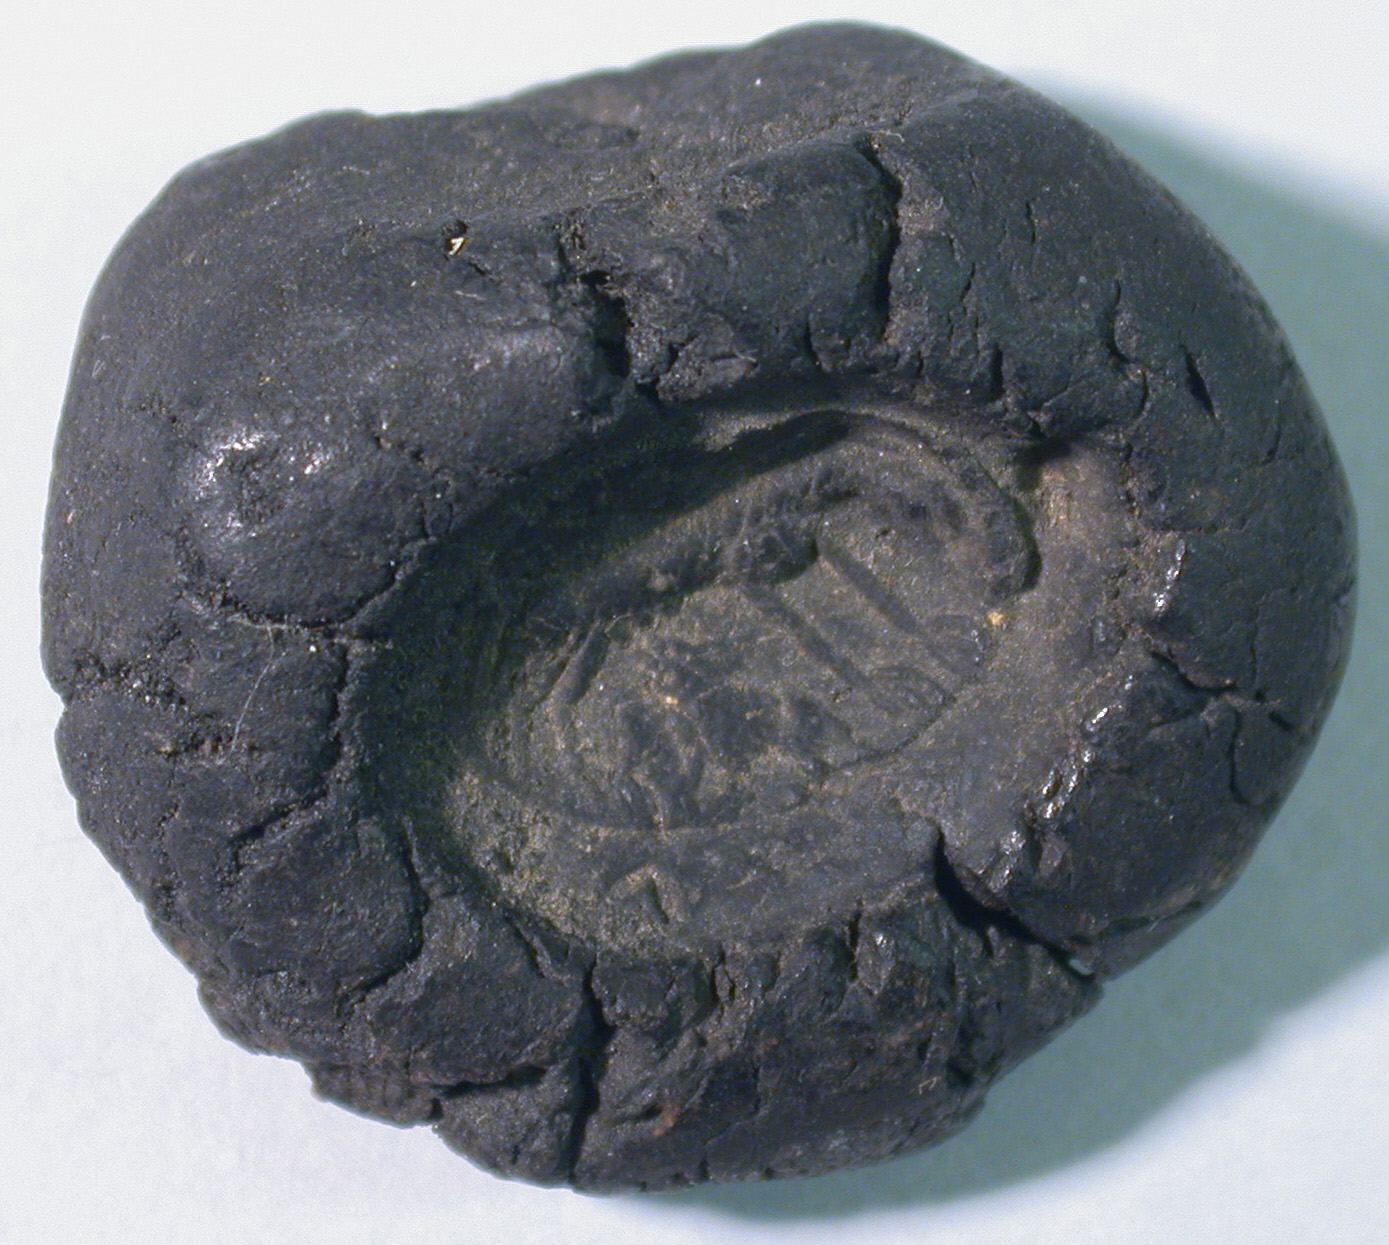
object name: sealing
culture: sasanian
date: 601-700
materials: clay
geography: iran